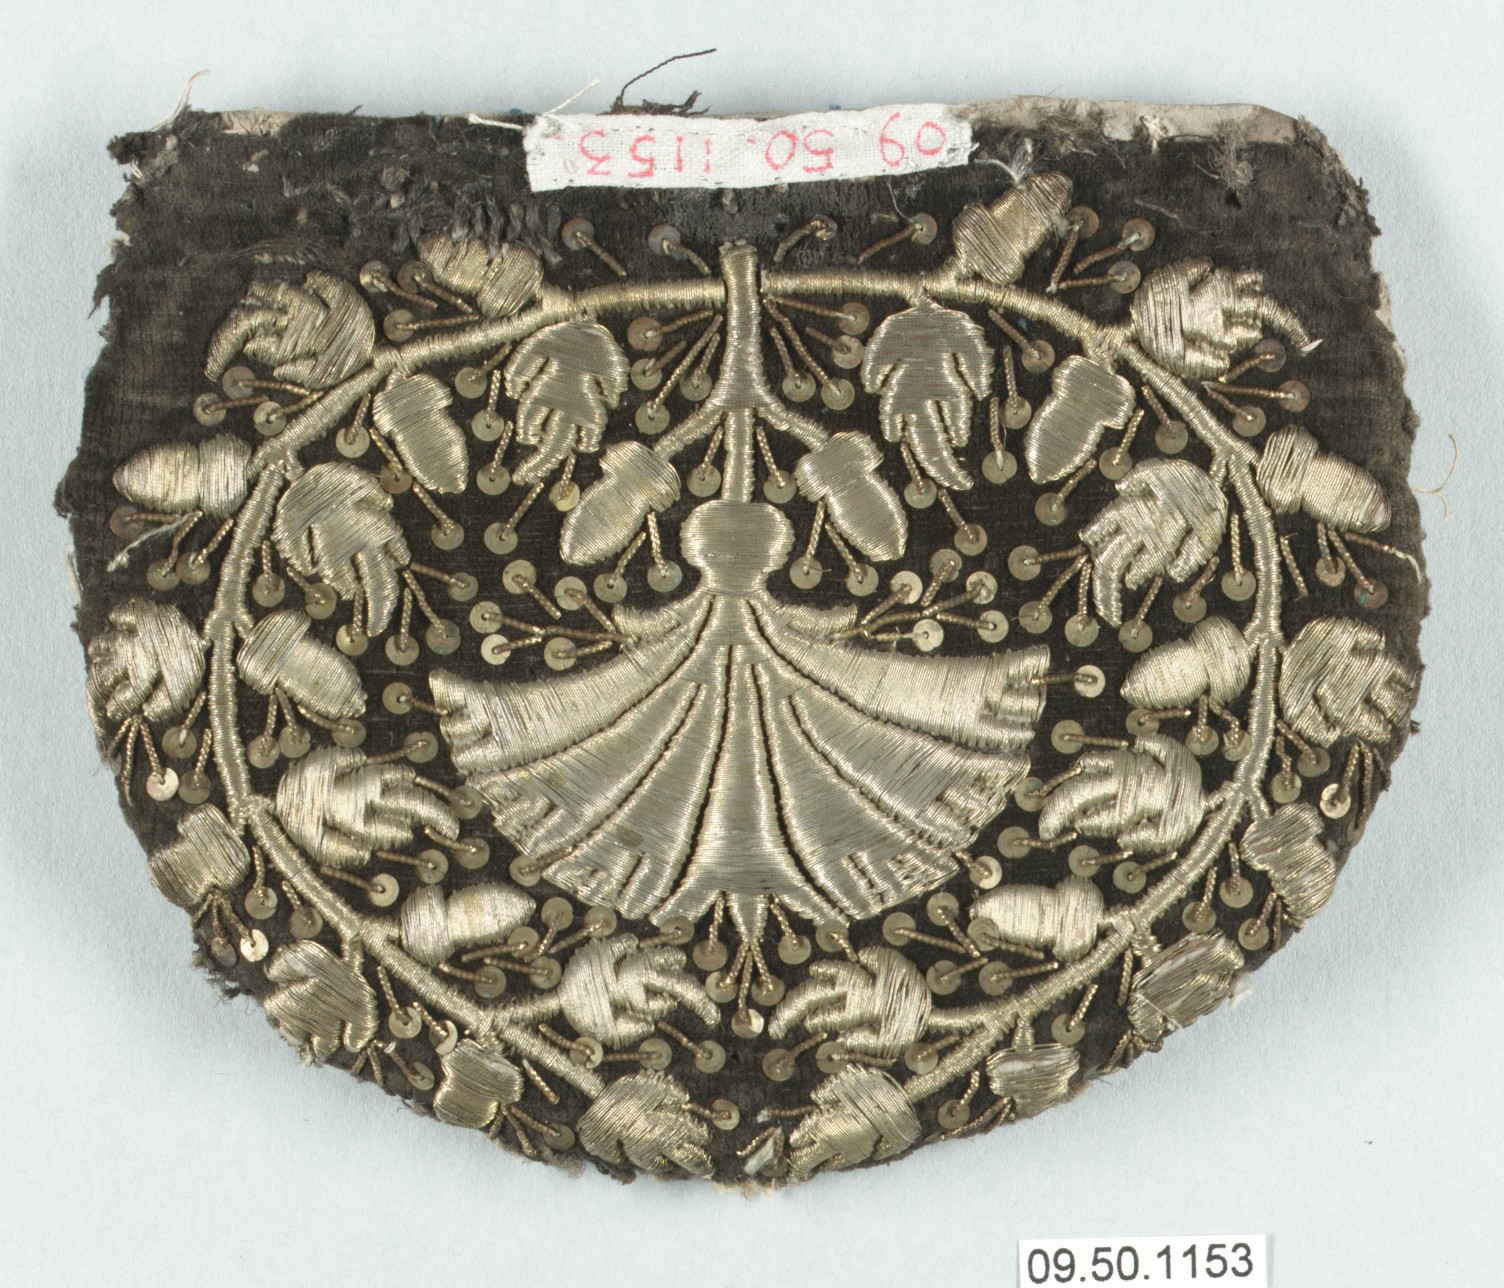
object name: cap crown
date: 1801-1900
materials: metal thread, velvet